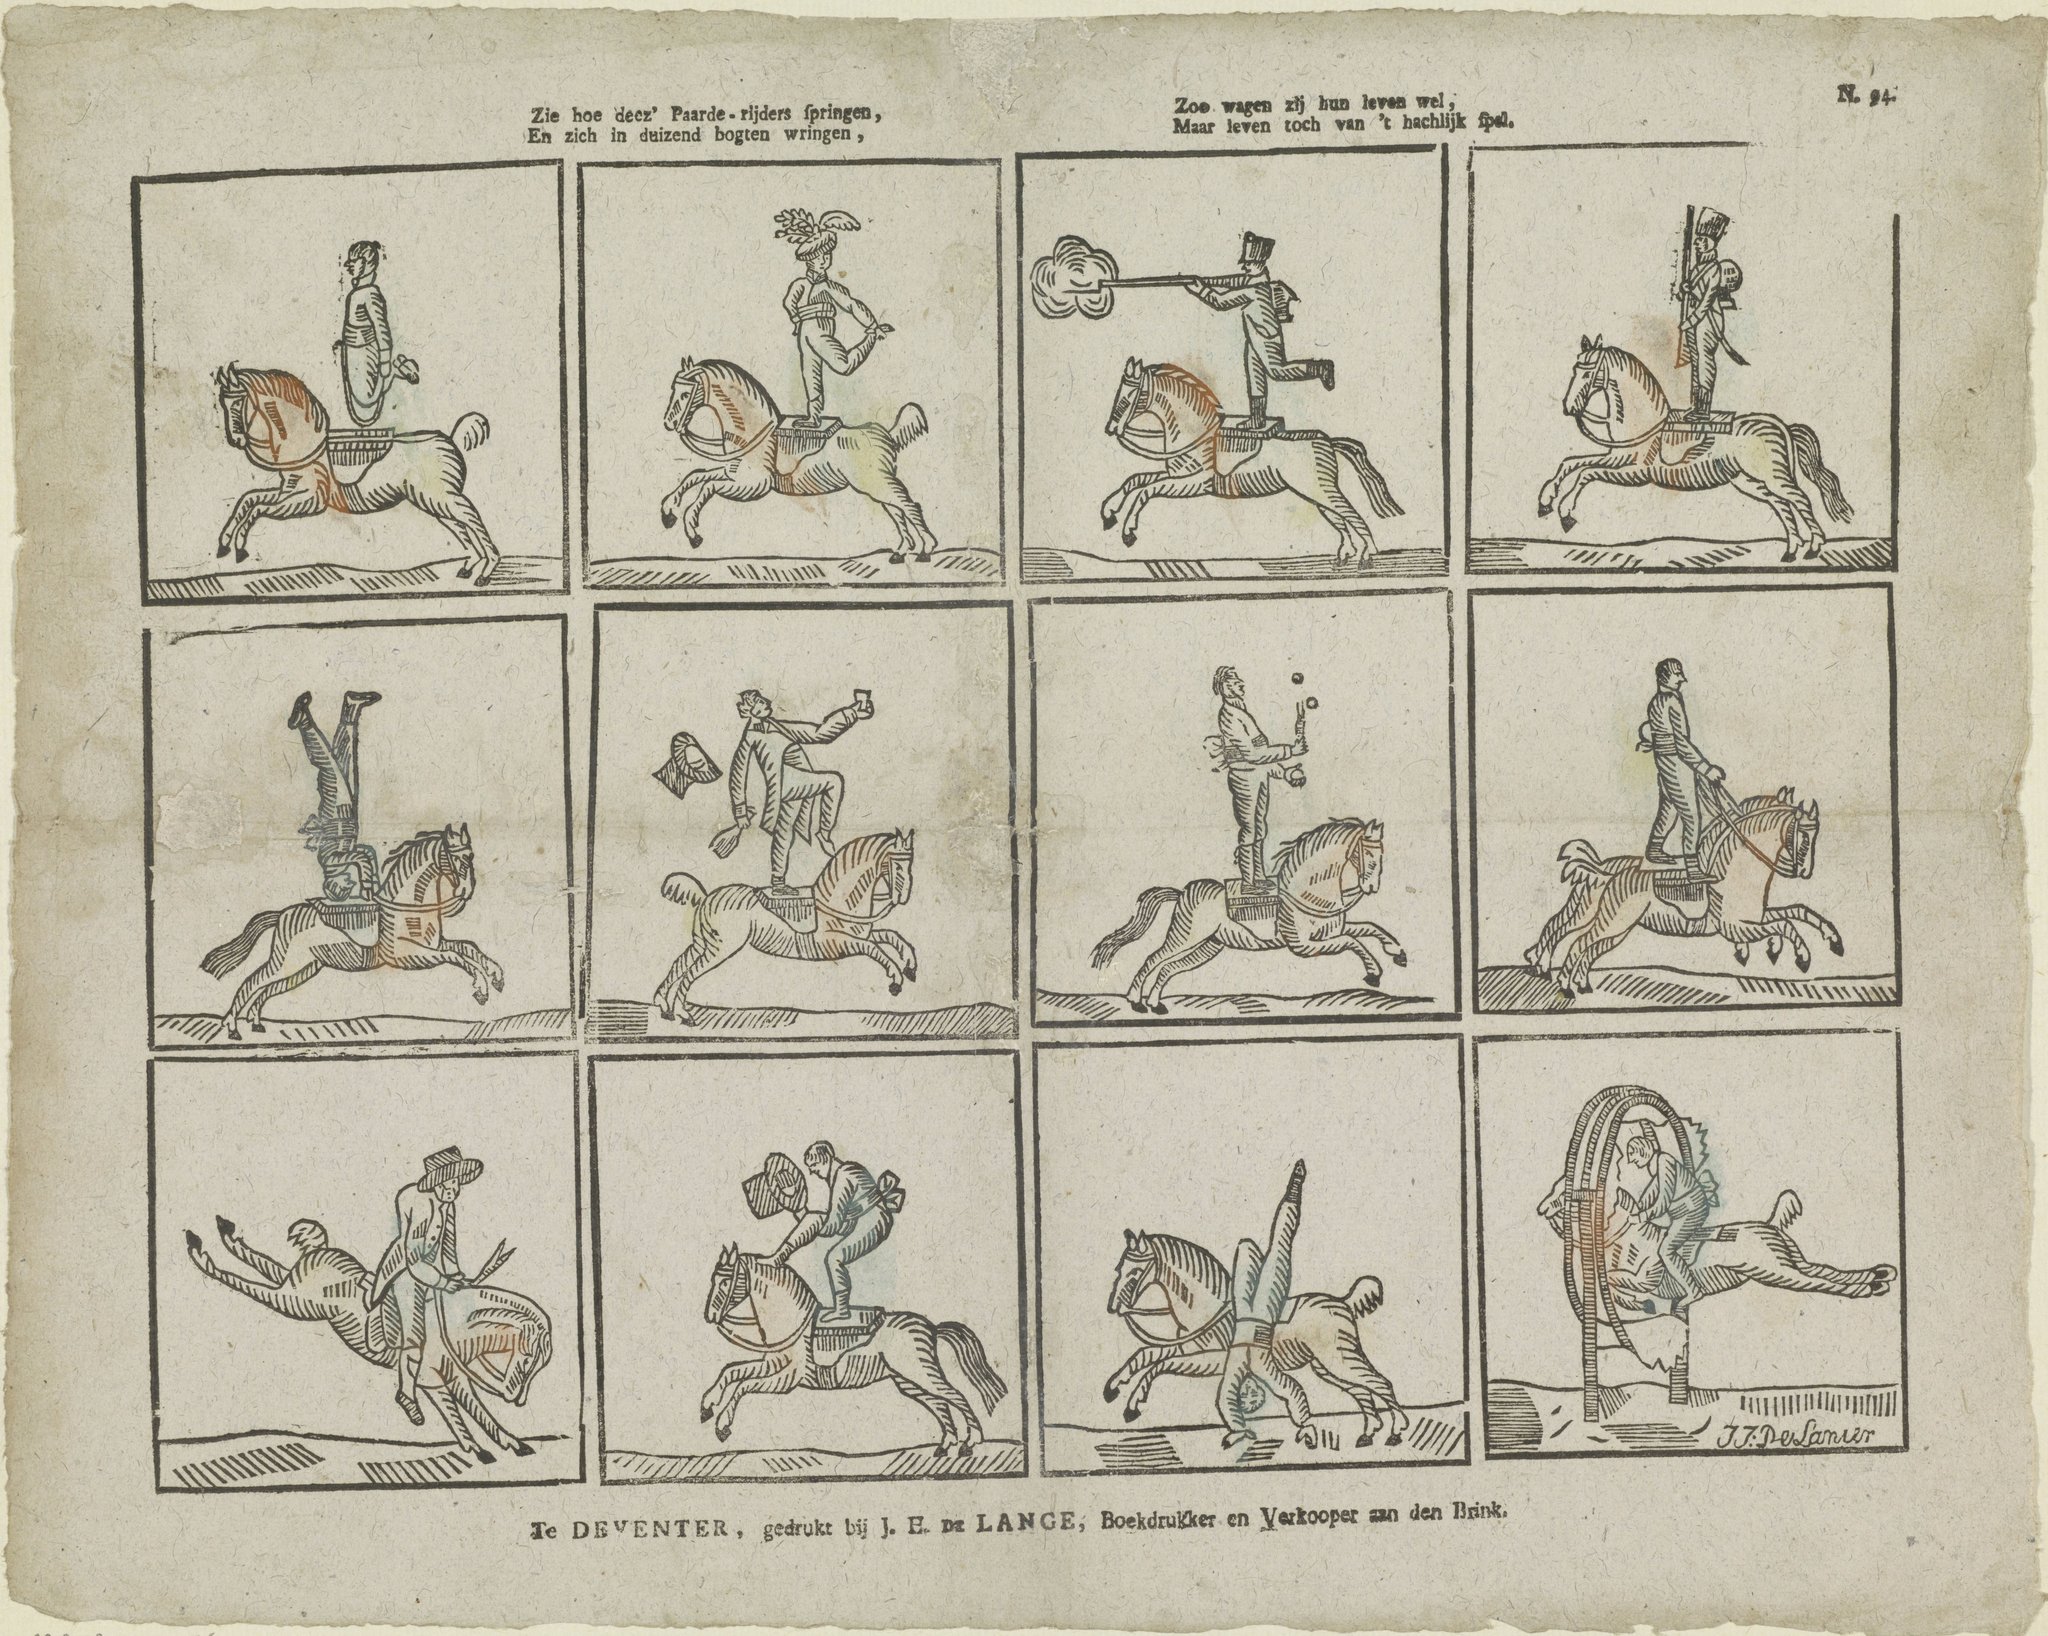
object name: popular print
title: Zie hier hoe deez' paarde-rijders springen, / En zich in duizend bogten wringen, / Zoo wagen zij hun leven wel, / Maar leven toch van 't hachlijk spel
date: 1787-1822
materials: paper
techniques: colour, letterpress printing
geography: netherlands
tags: horses (circus performance)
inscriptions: collector's mark: Lugt 2760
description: Blad met 12 voorstellingen van acrobaten die verschillende kunsten op een paard uitvoeren. Genummerd rechtsboven: N. 94.